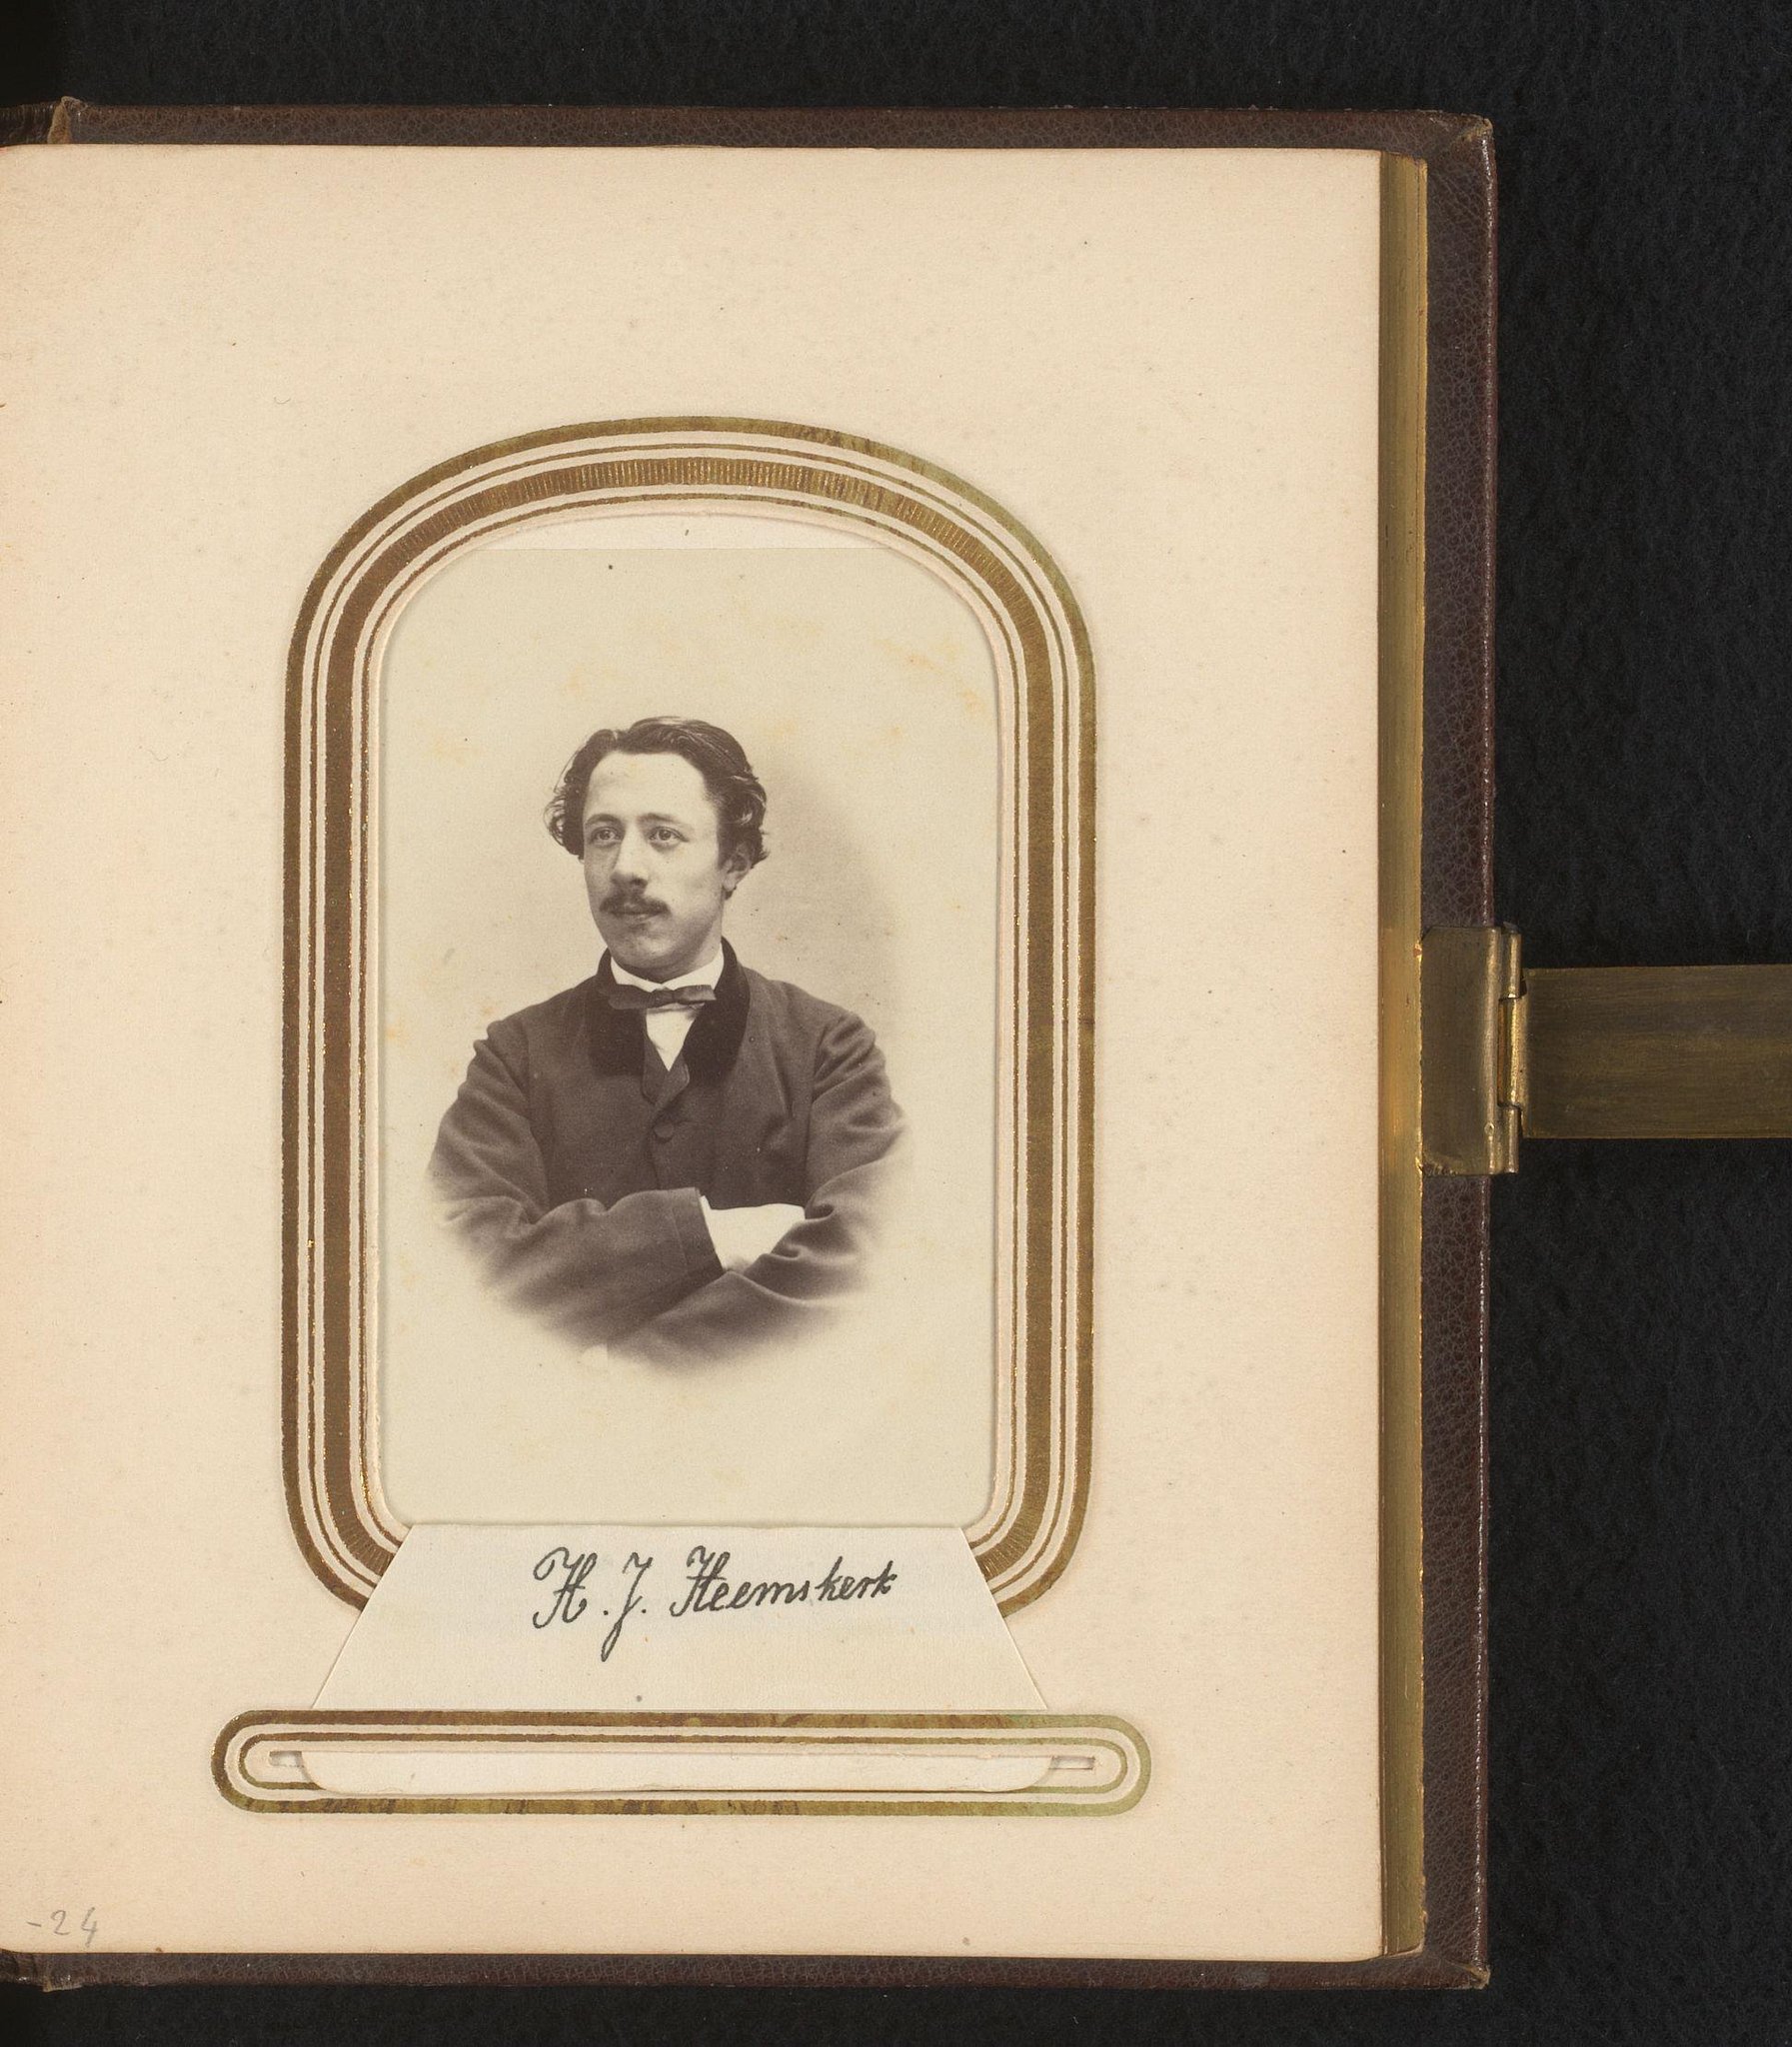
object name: album leaf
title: Portret van Hendrik Jan Heemskerk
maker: Anonymous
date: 1865-1875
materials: cardboard, paper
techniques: albumen print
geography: amsterdam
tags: haarlem, amsterdam, historical persons